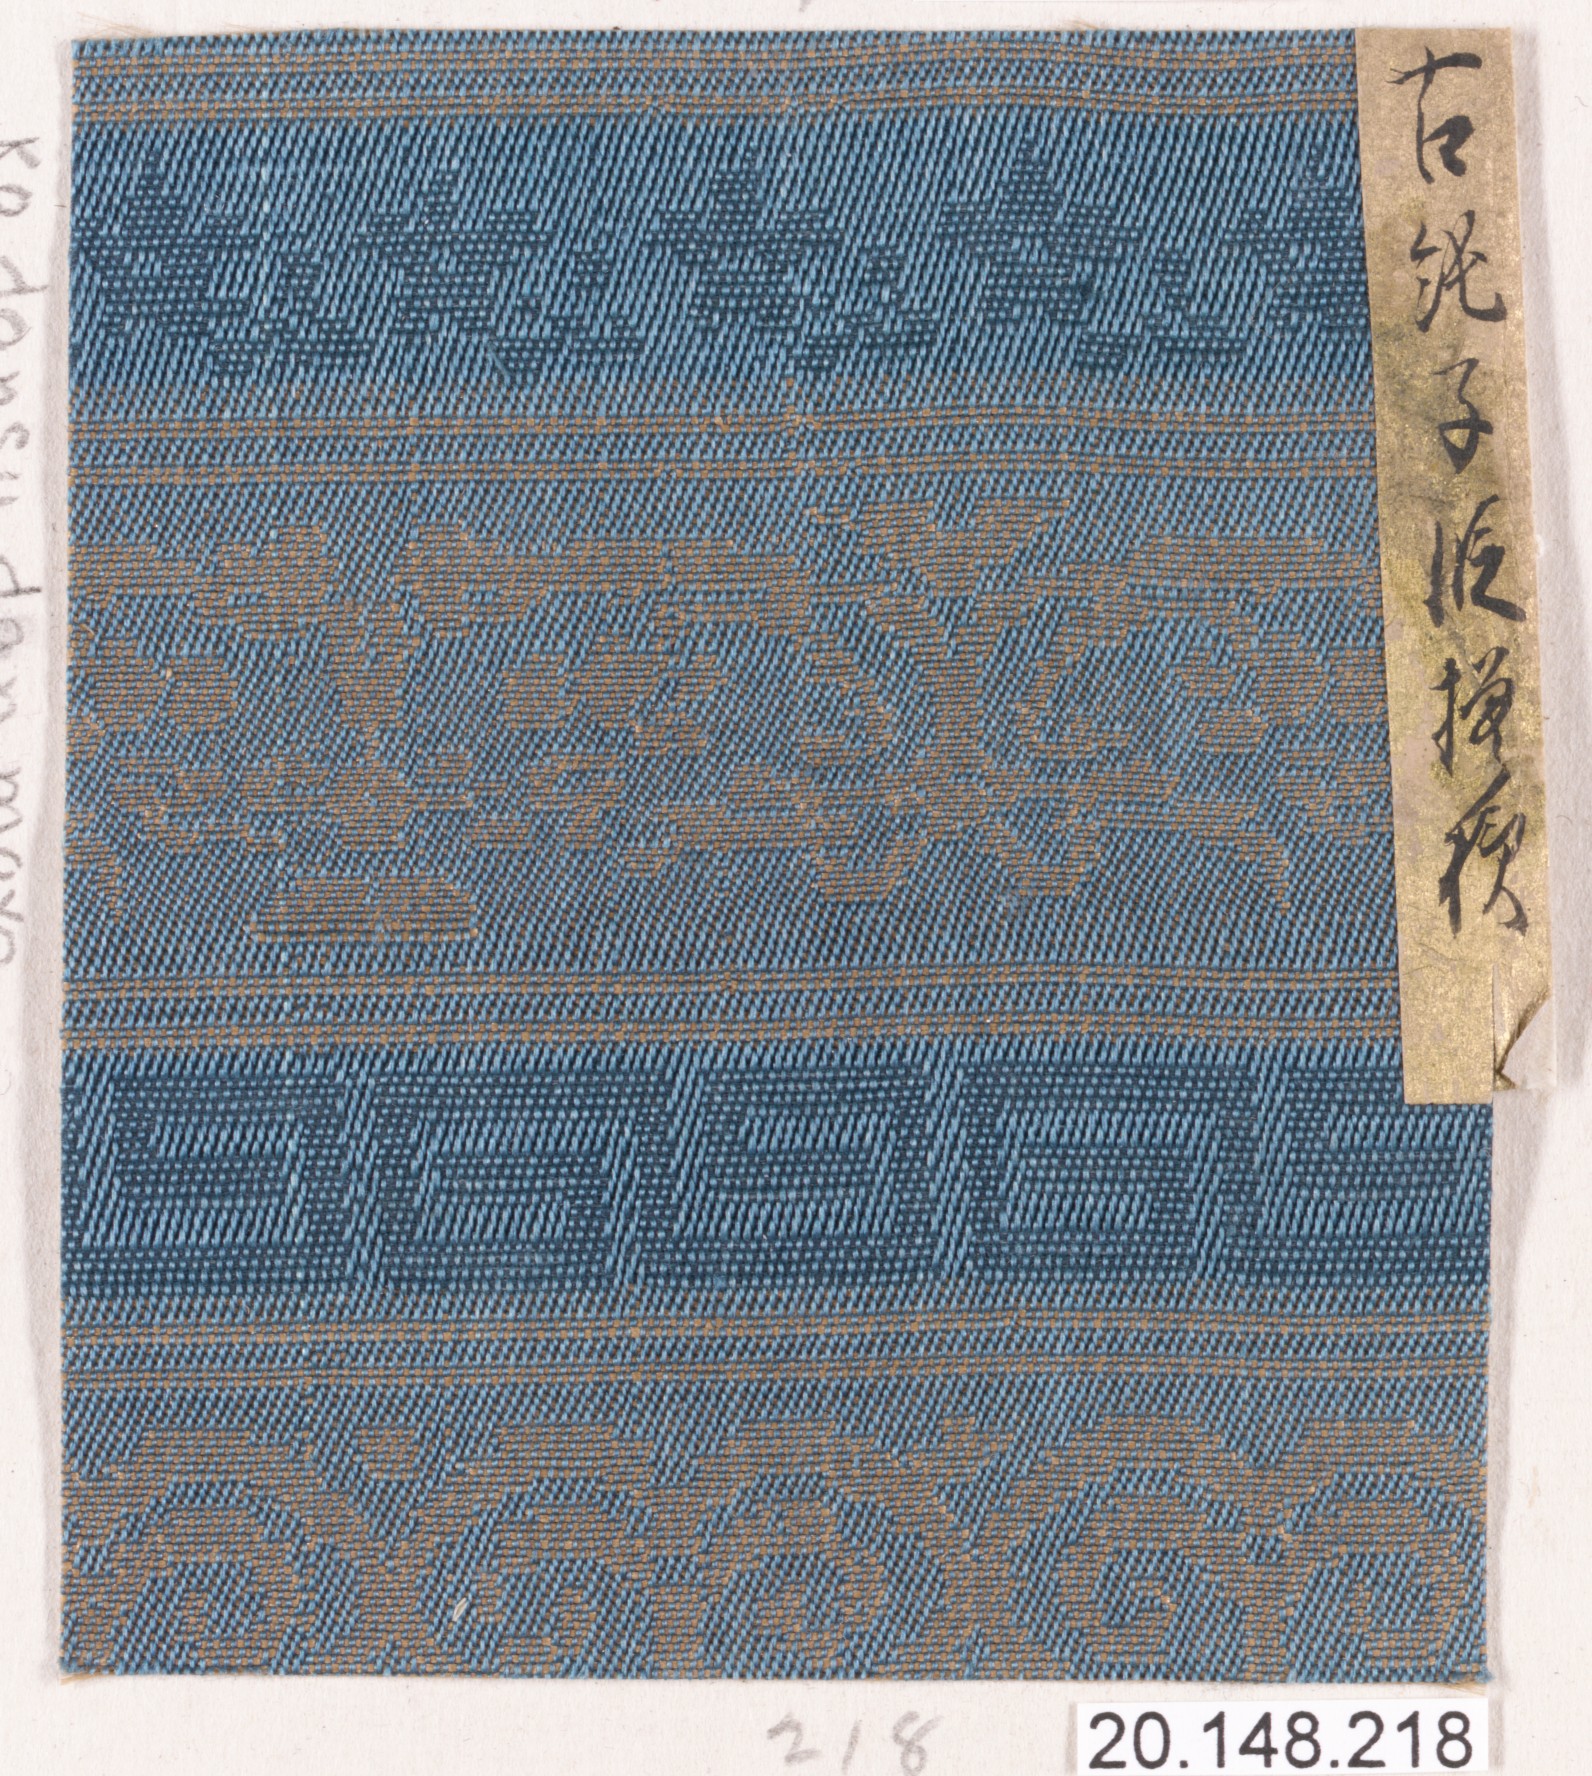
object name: piece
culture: china or japan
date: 1701-1800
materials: silk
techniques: compound weave